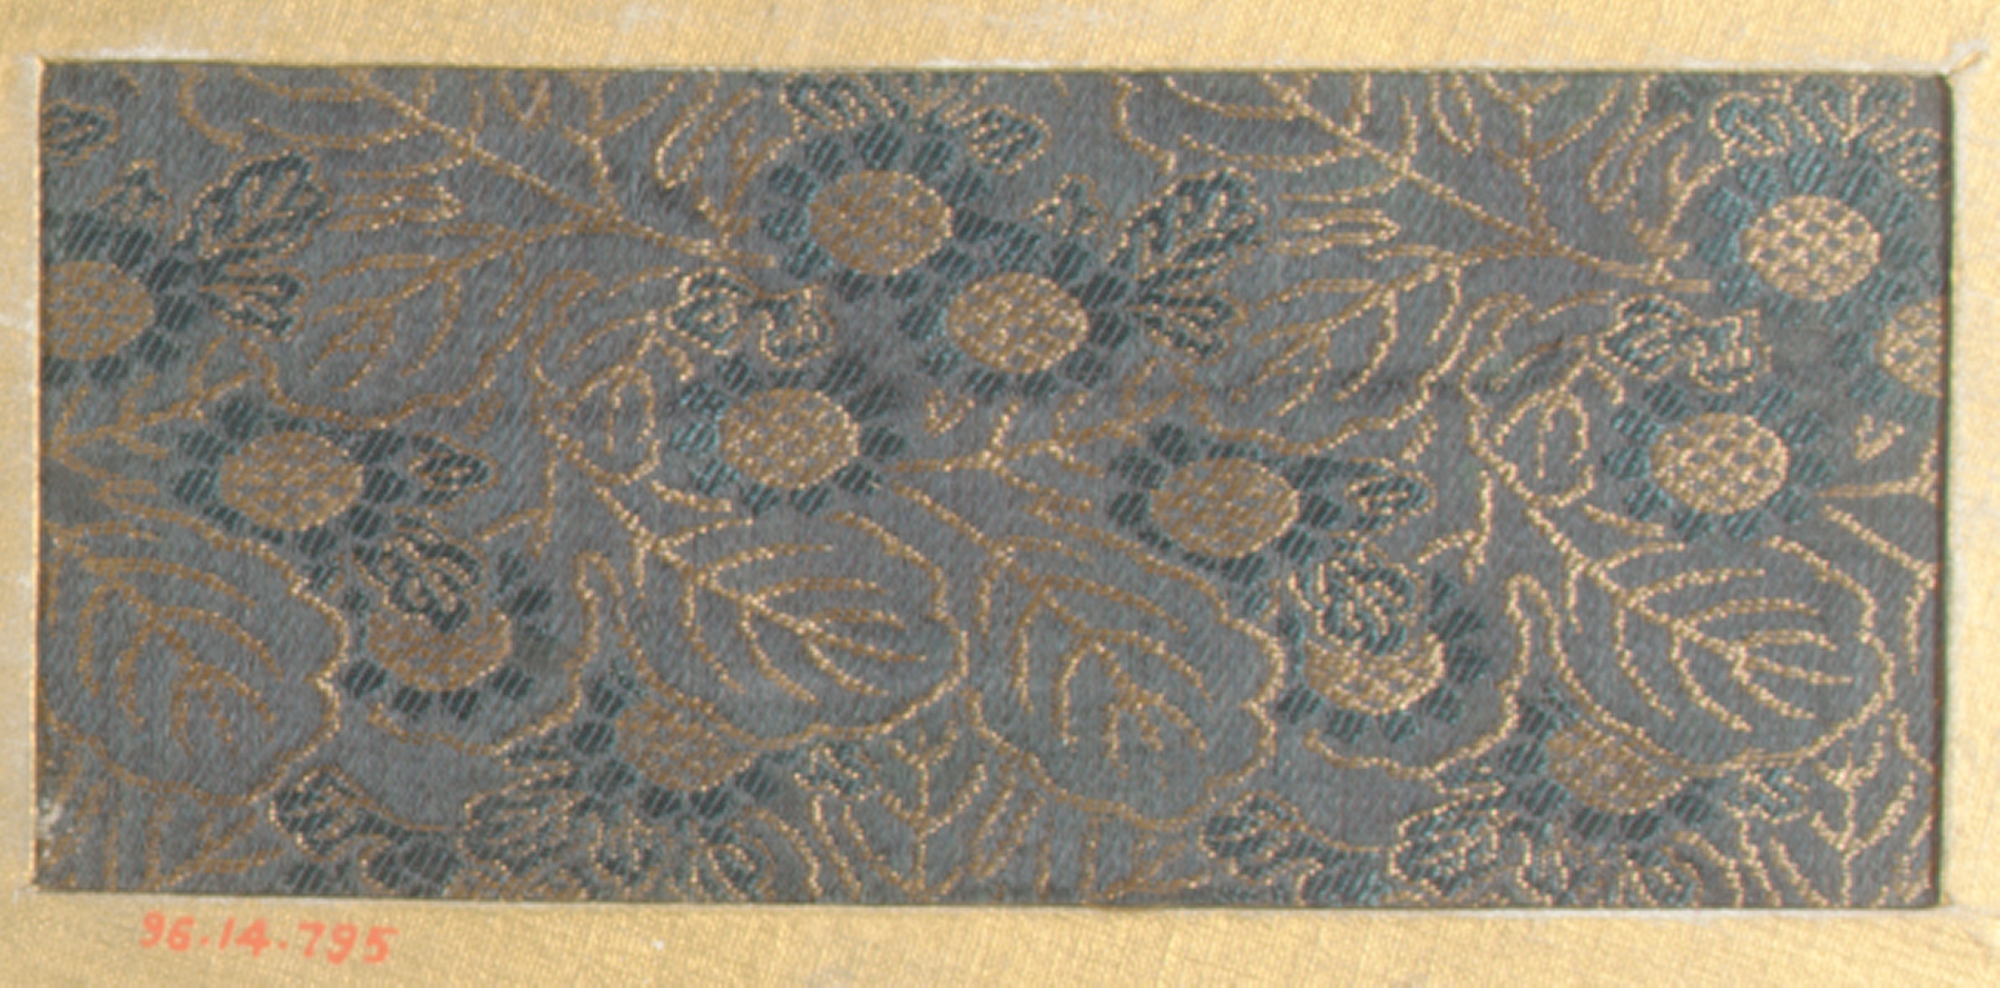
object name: piece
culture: japanese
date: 1701-1900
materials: silk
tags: leaves